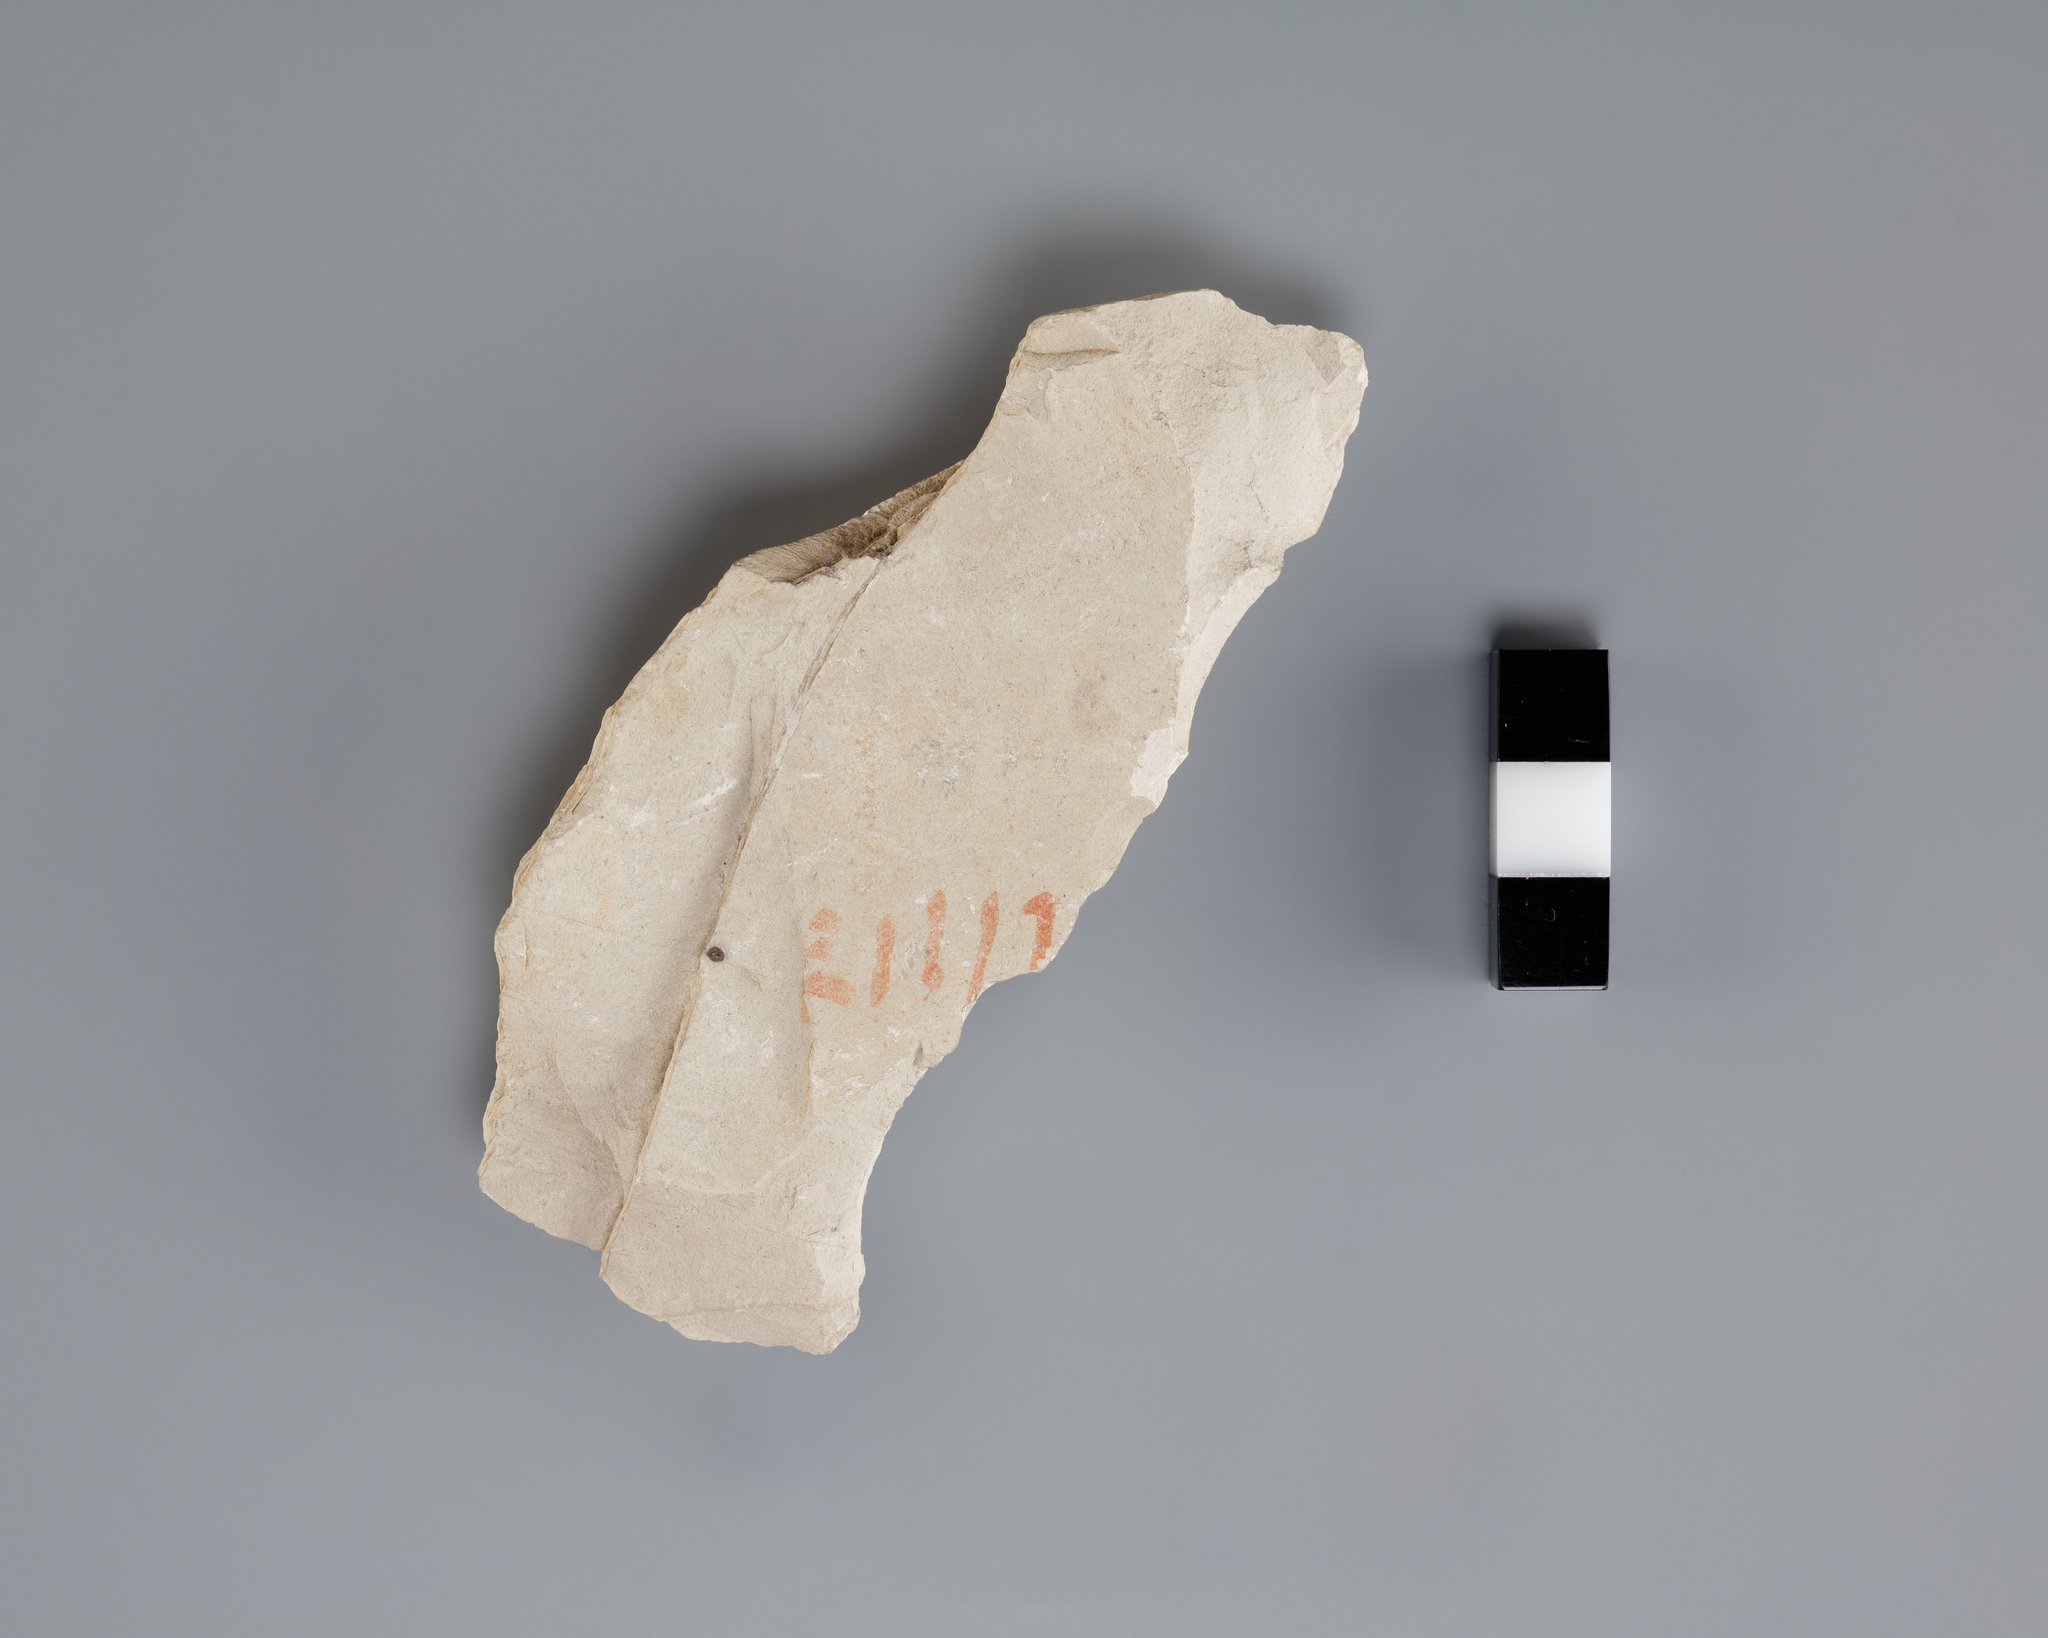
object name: ostracon, hieratic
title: Hieratic ostracon with remains of red numeral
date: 1295-1070 BCE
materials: ink, limestone, paint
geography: egypt